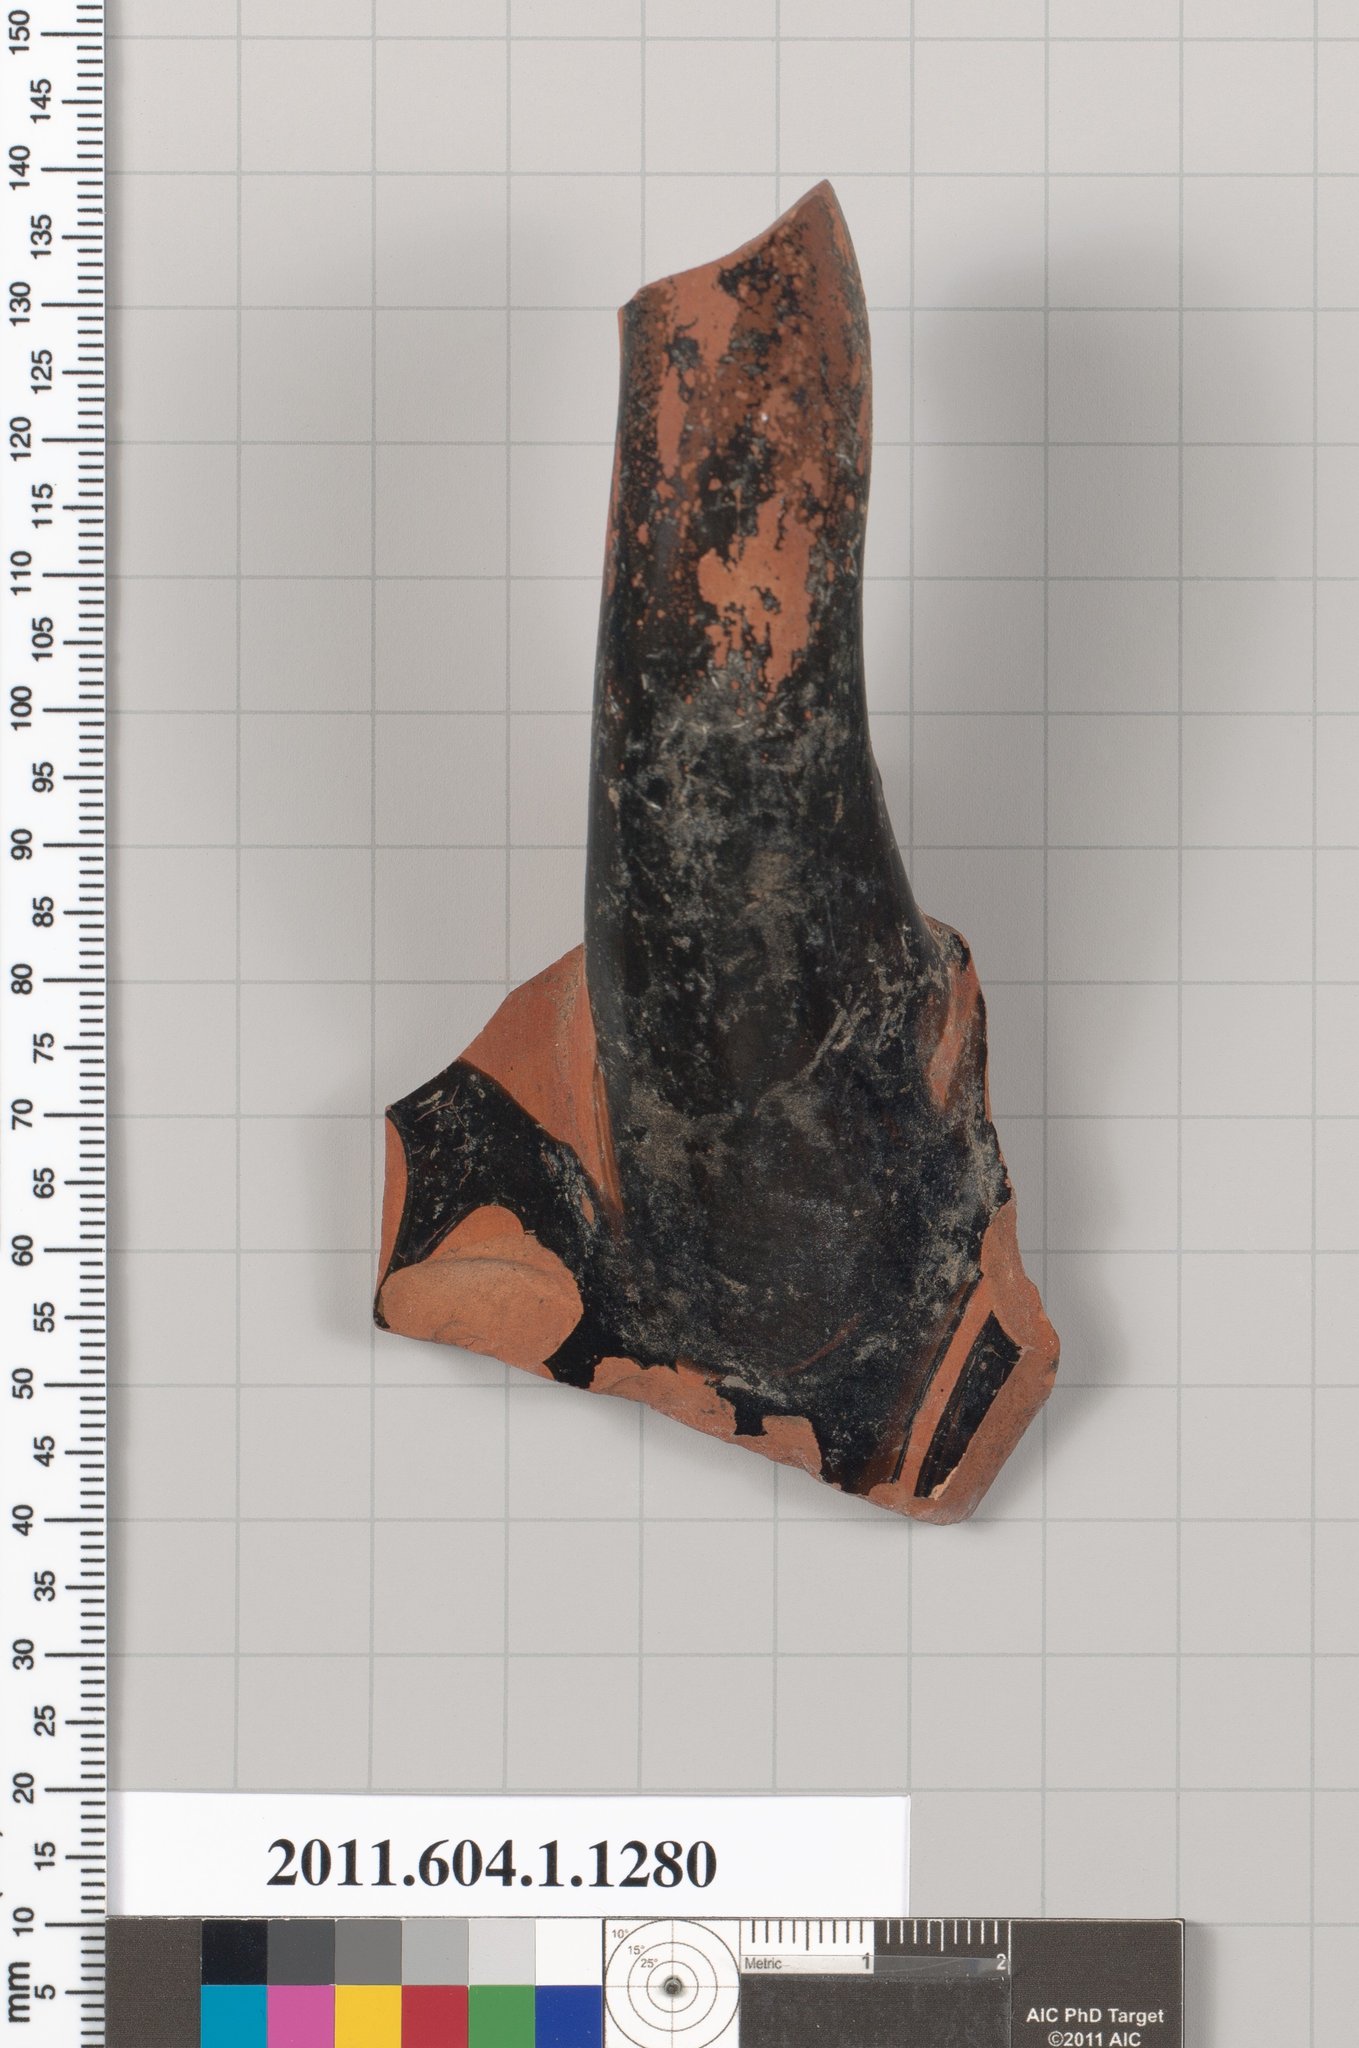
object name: kylix fragment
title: Terracotta fragment of kylix (drinking cup)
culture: greek, attic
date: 500-401 BCE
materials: terracotta